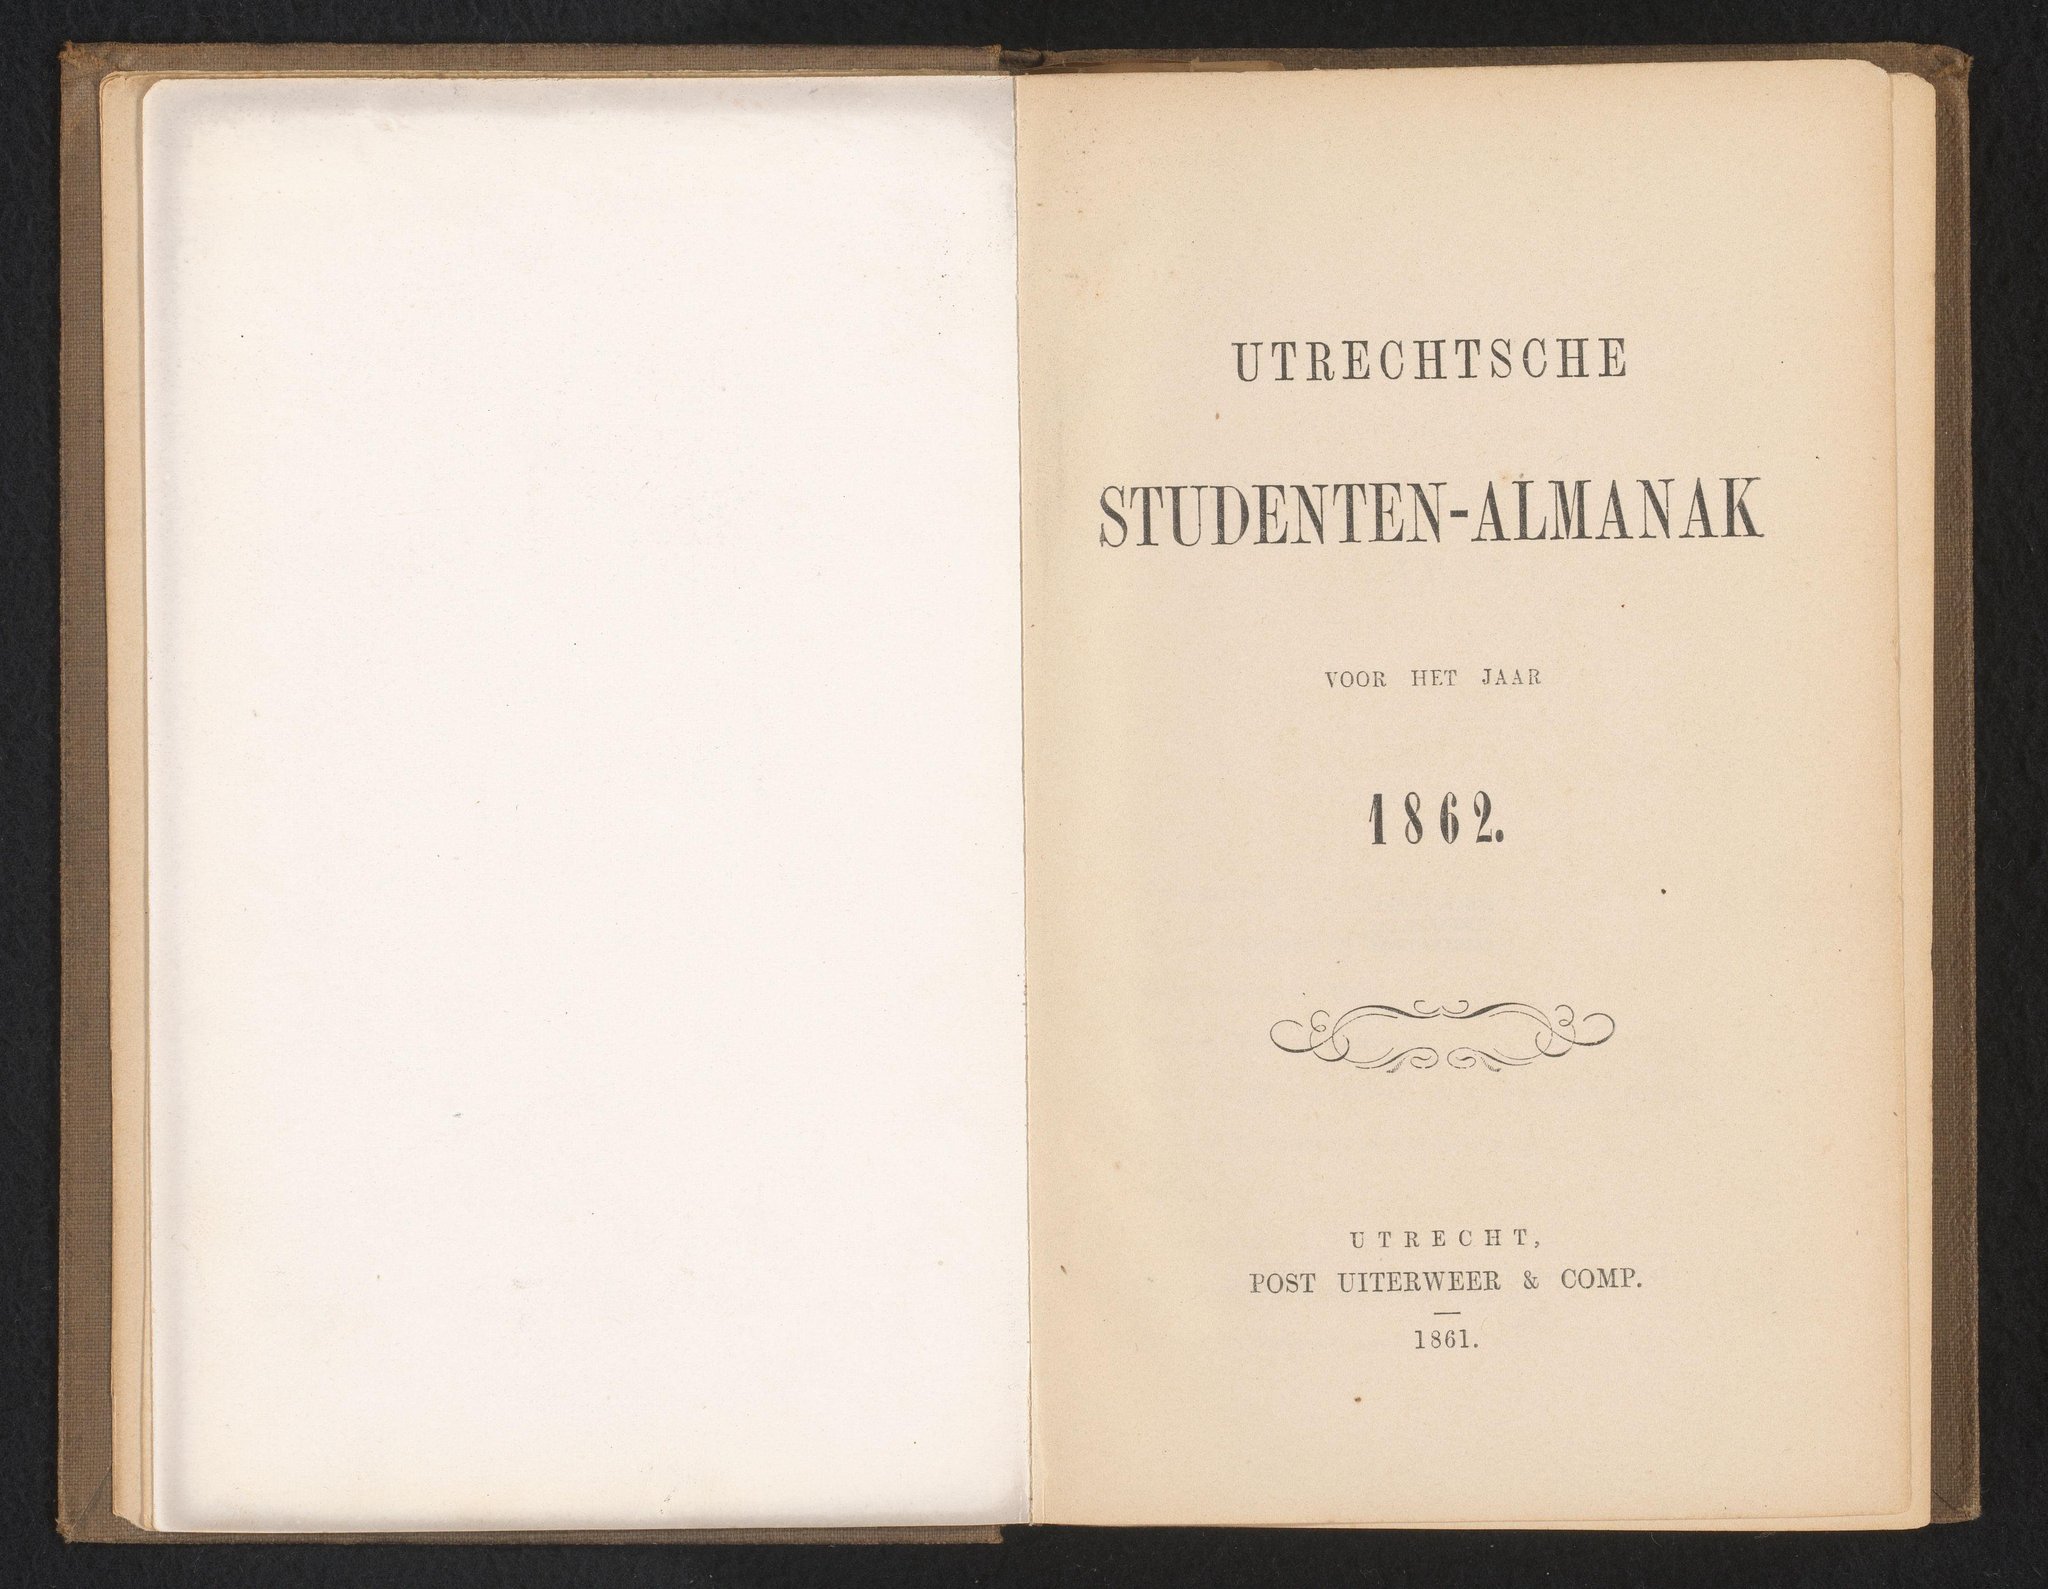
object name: book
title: Utrechtsche studenten-almanak voor het jaar 1862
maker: j.g. andriessen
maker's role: printer, publisher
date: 1861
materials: paper, cardboard, linen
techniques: albumen print, engraving, letterpress printing, lithograph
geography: utrecht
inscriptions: inscription: ‘750805/ 15,-’